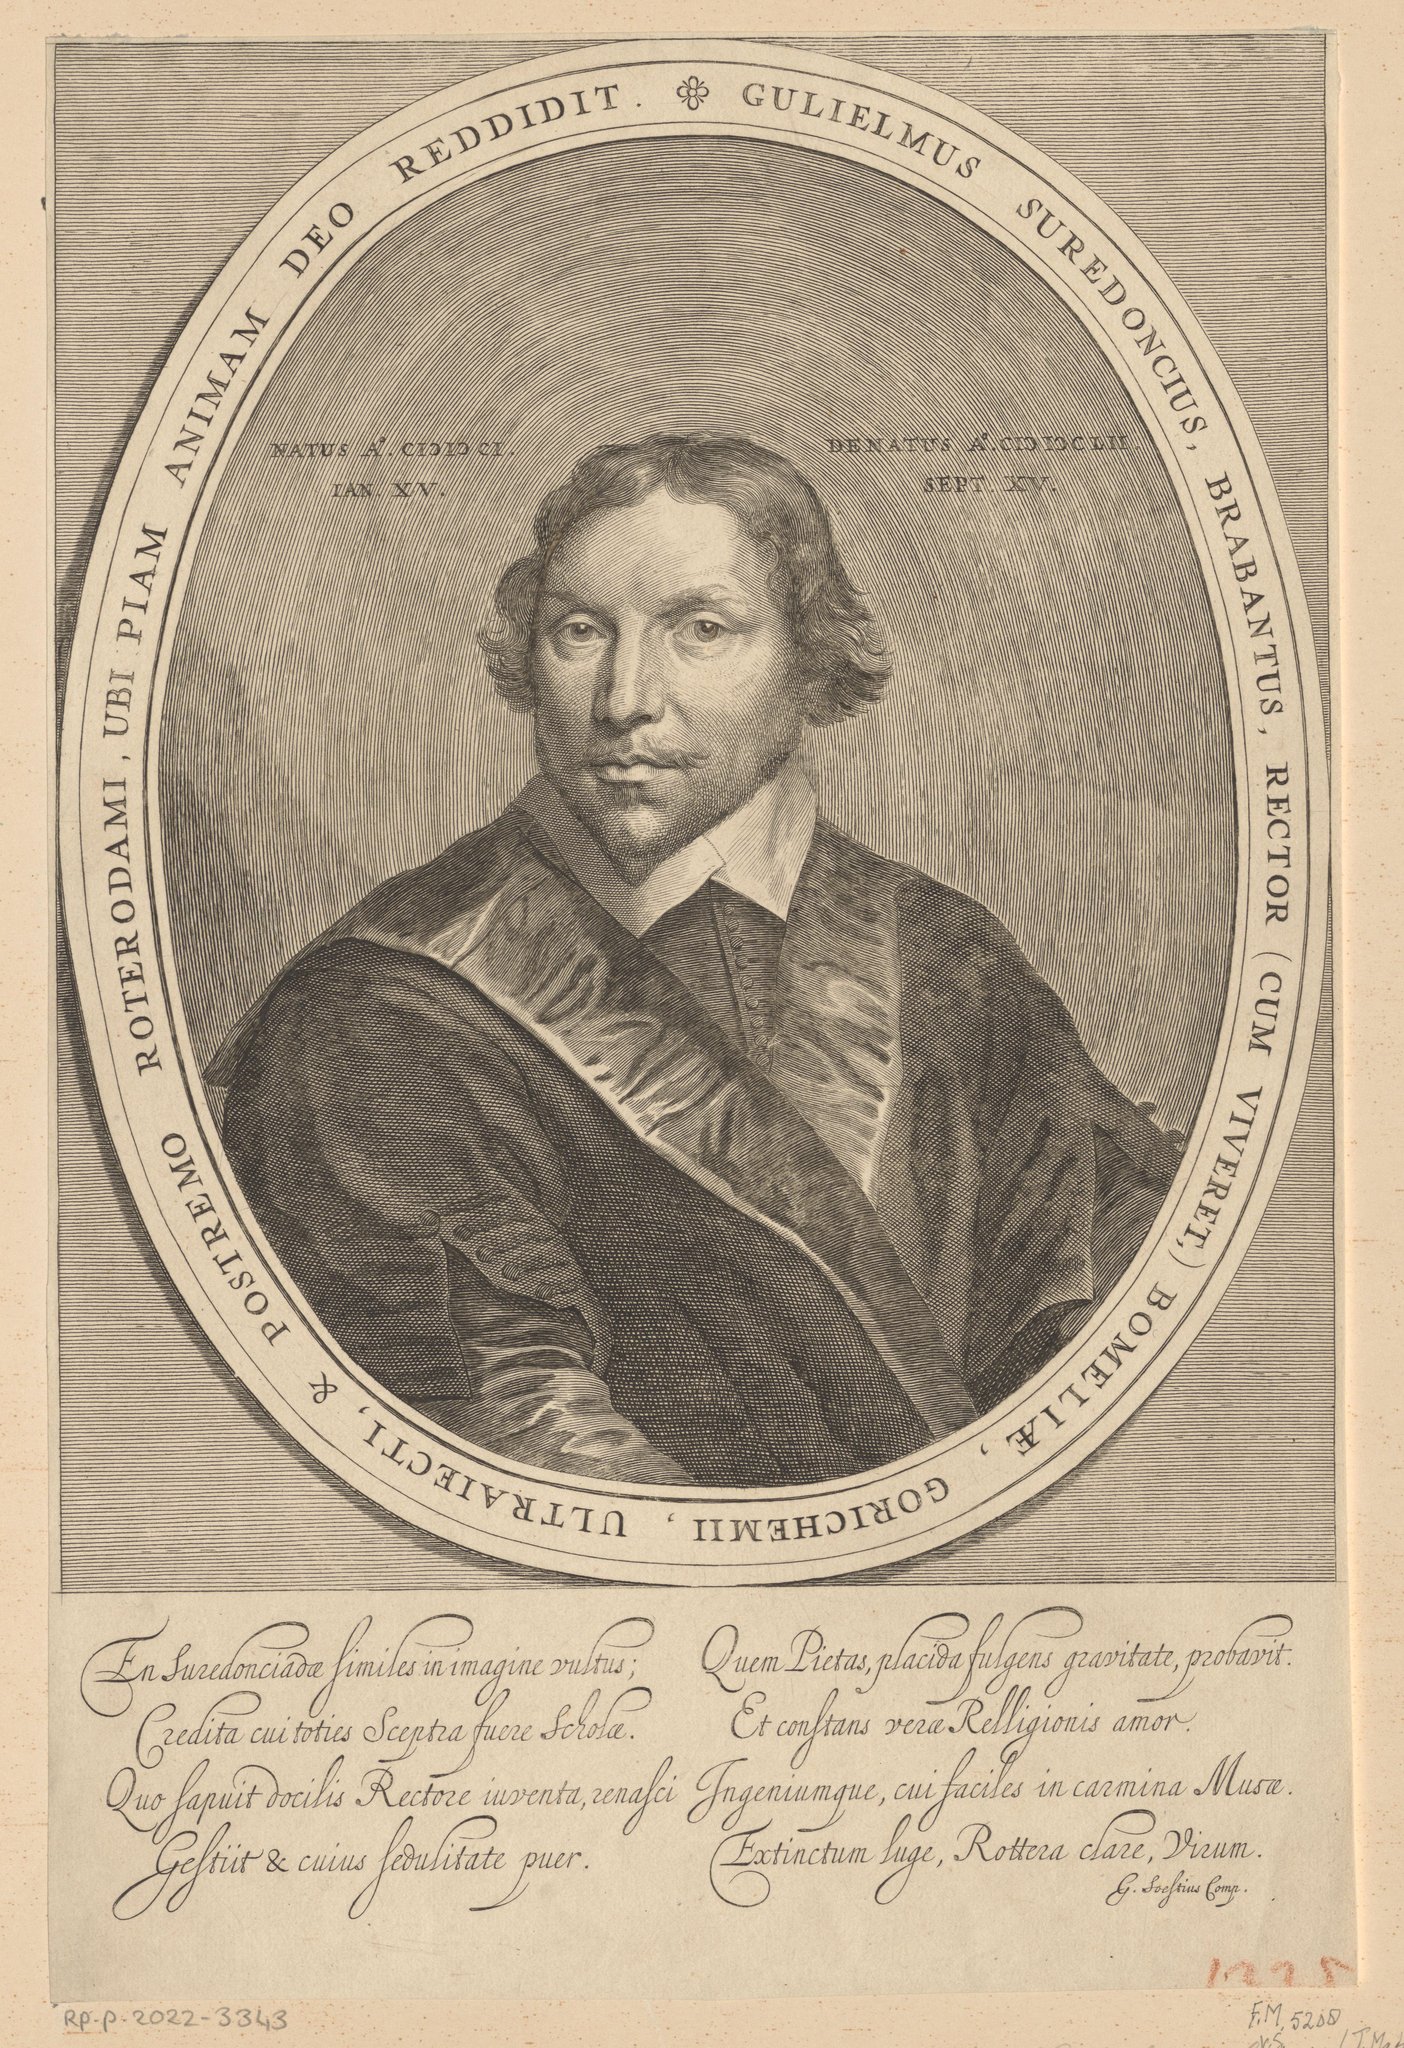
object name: print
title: Portret van Guilielmus Surendonck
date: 1652-1676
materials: paper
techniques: engraving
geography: northern netherlands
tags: guilielmus surendonck, historical persons, portrait of a writer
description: Met achtregelig vers in het Latijn in twee kolommen.